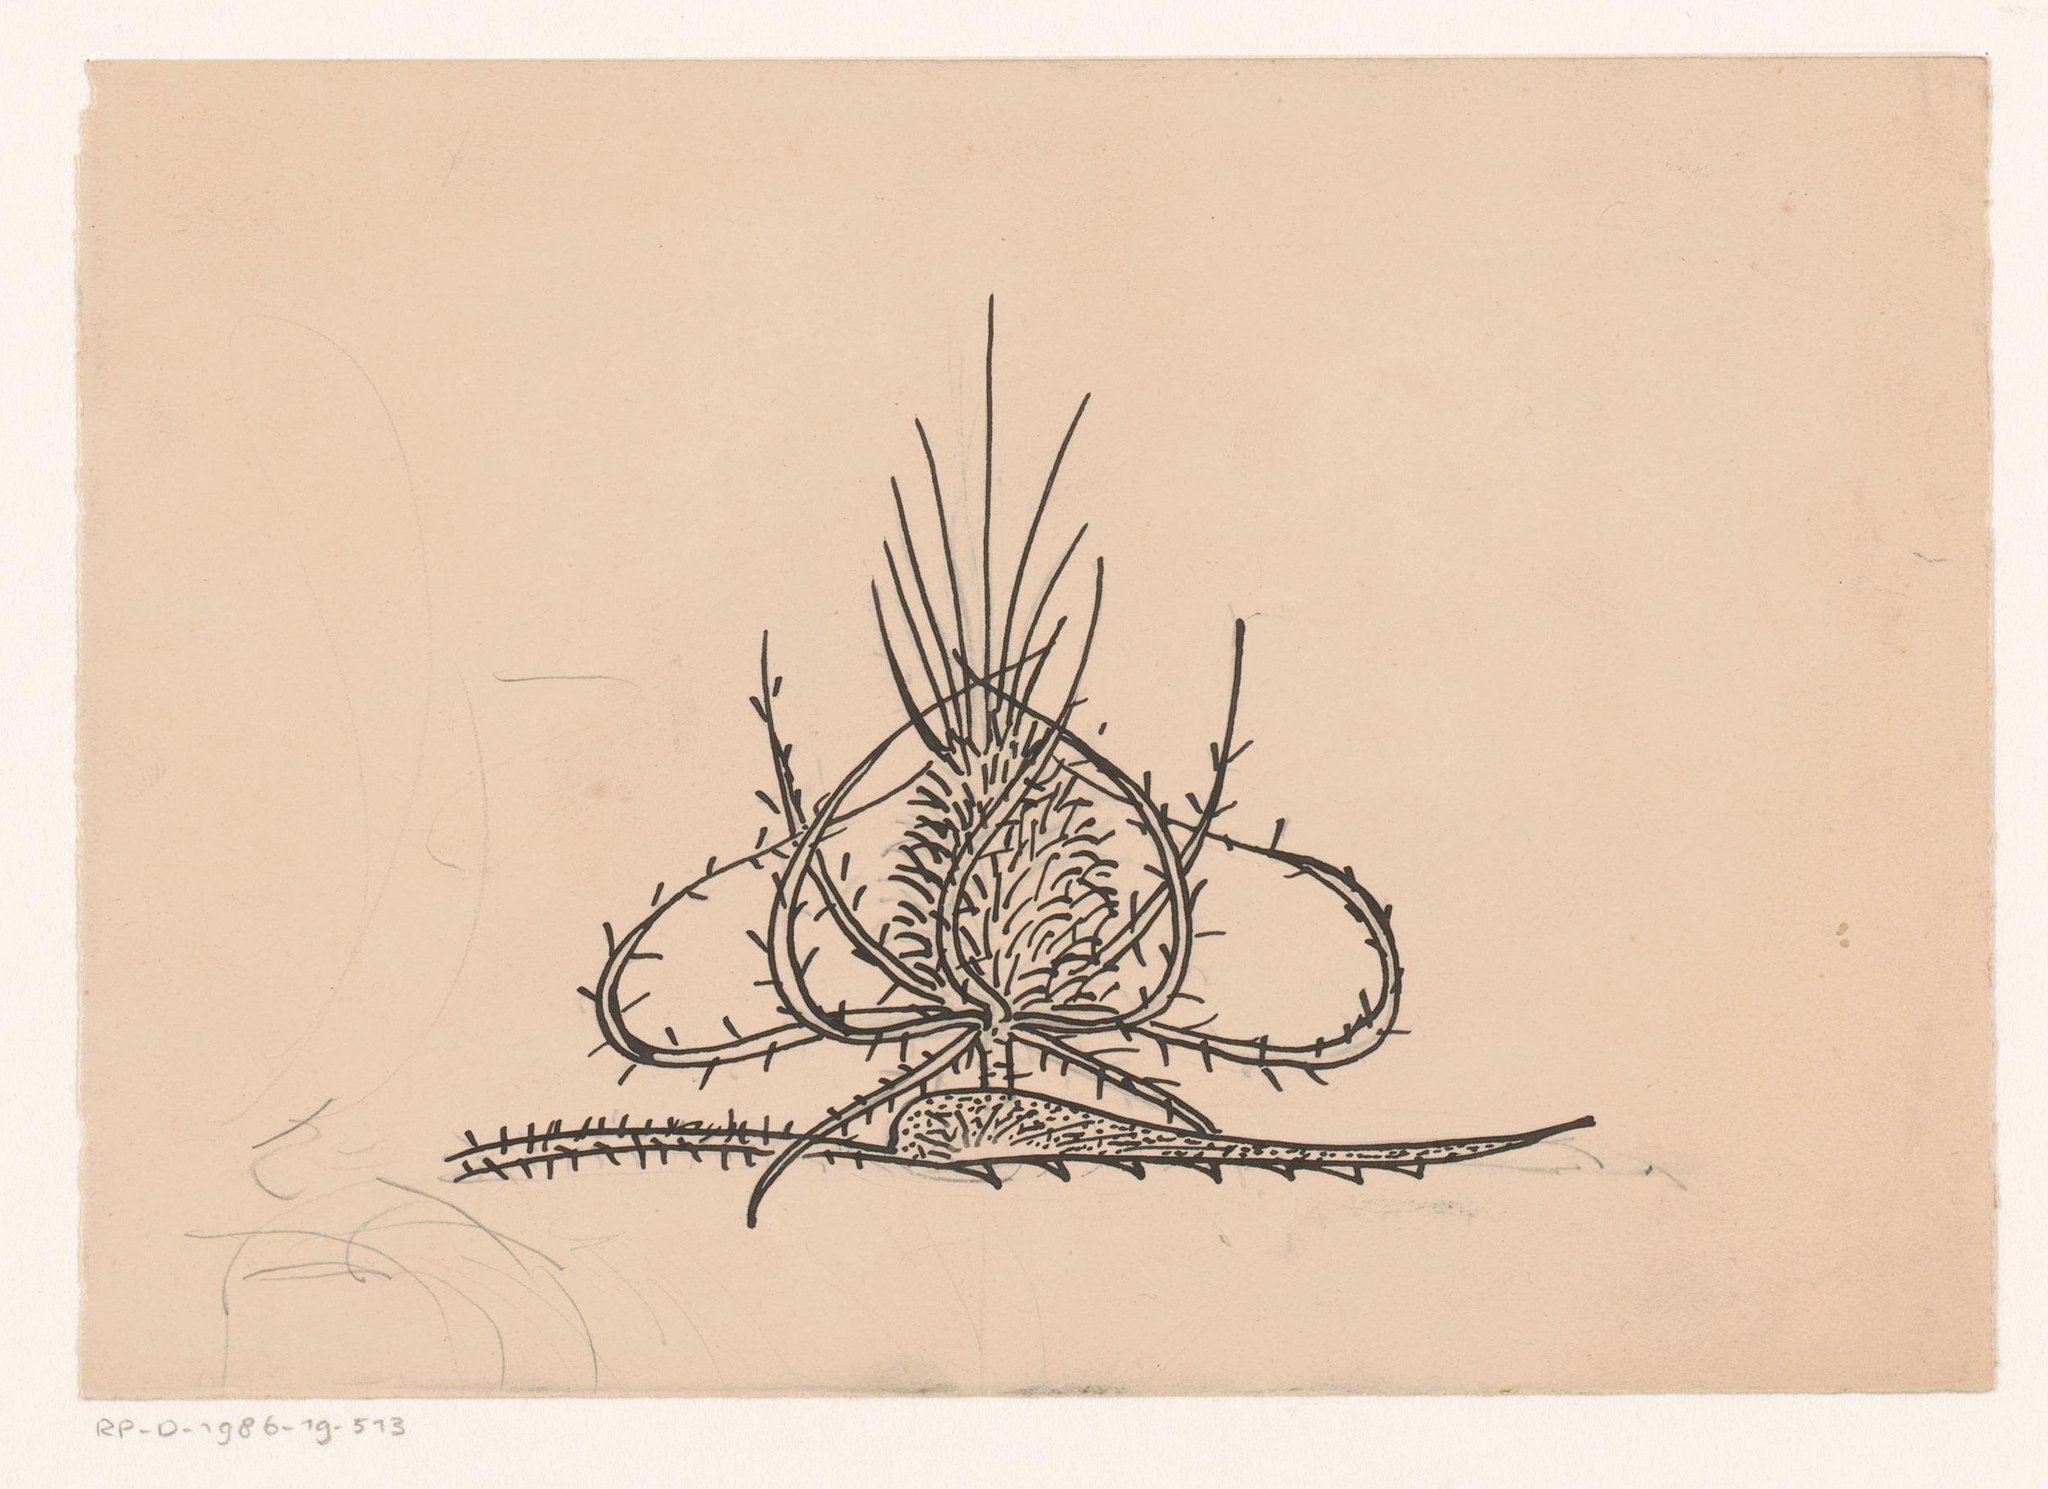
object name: drawing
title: Vignet met distel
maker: reinier willem petrus de vries (1874-1953)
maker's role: draughtsman, print maker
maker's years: 1874-1953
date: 1884-1952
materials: ink, paper, pencil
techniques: pen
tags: plants and herbs: thistle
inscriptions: collector's mark: ‘R:MVS.’